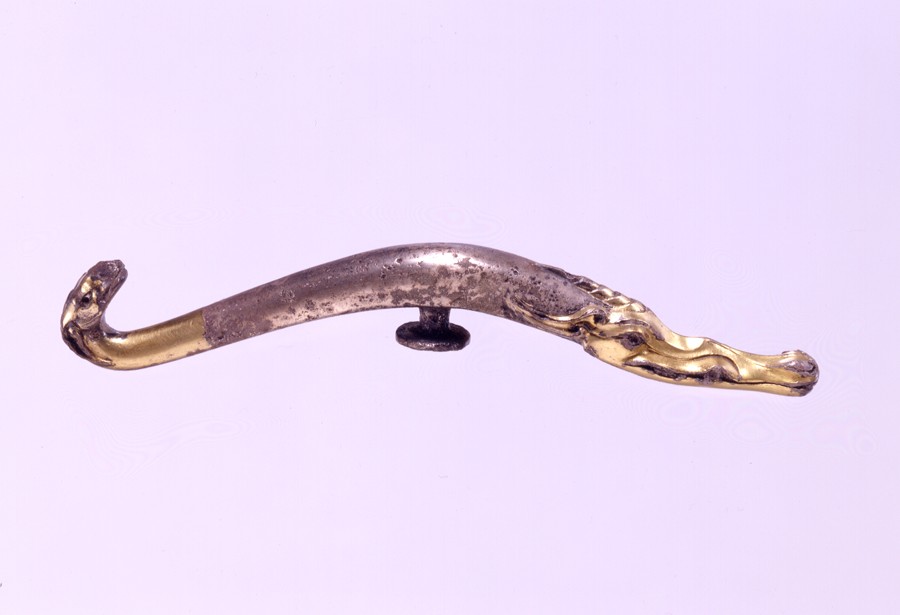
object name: belt hook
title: Belt Hook in the Shape of a Sinuous Creature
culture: chinese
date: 206 BCE-9 CE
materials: gold foil, silver